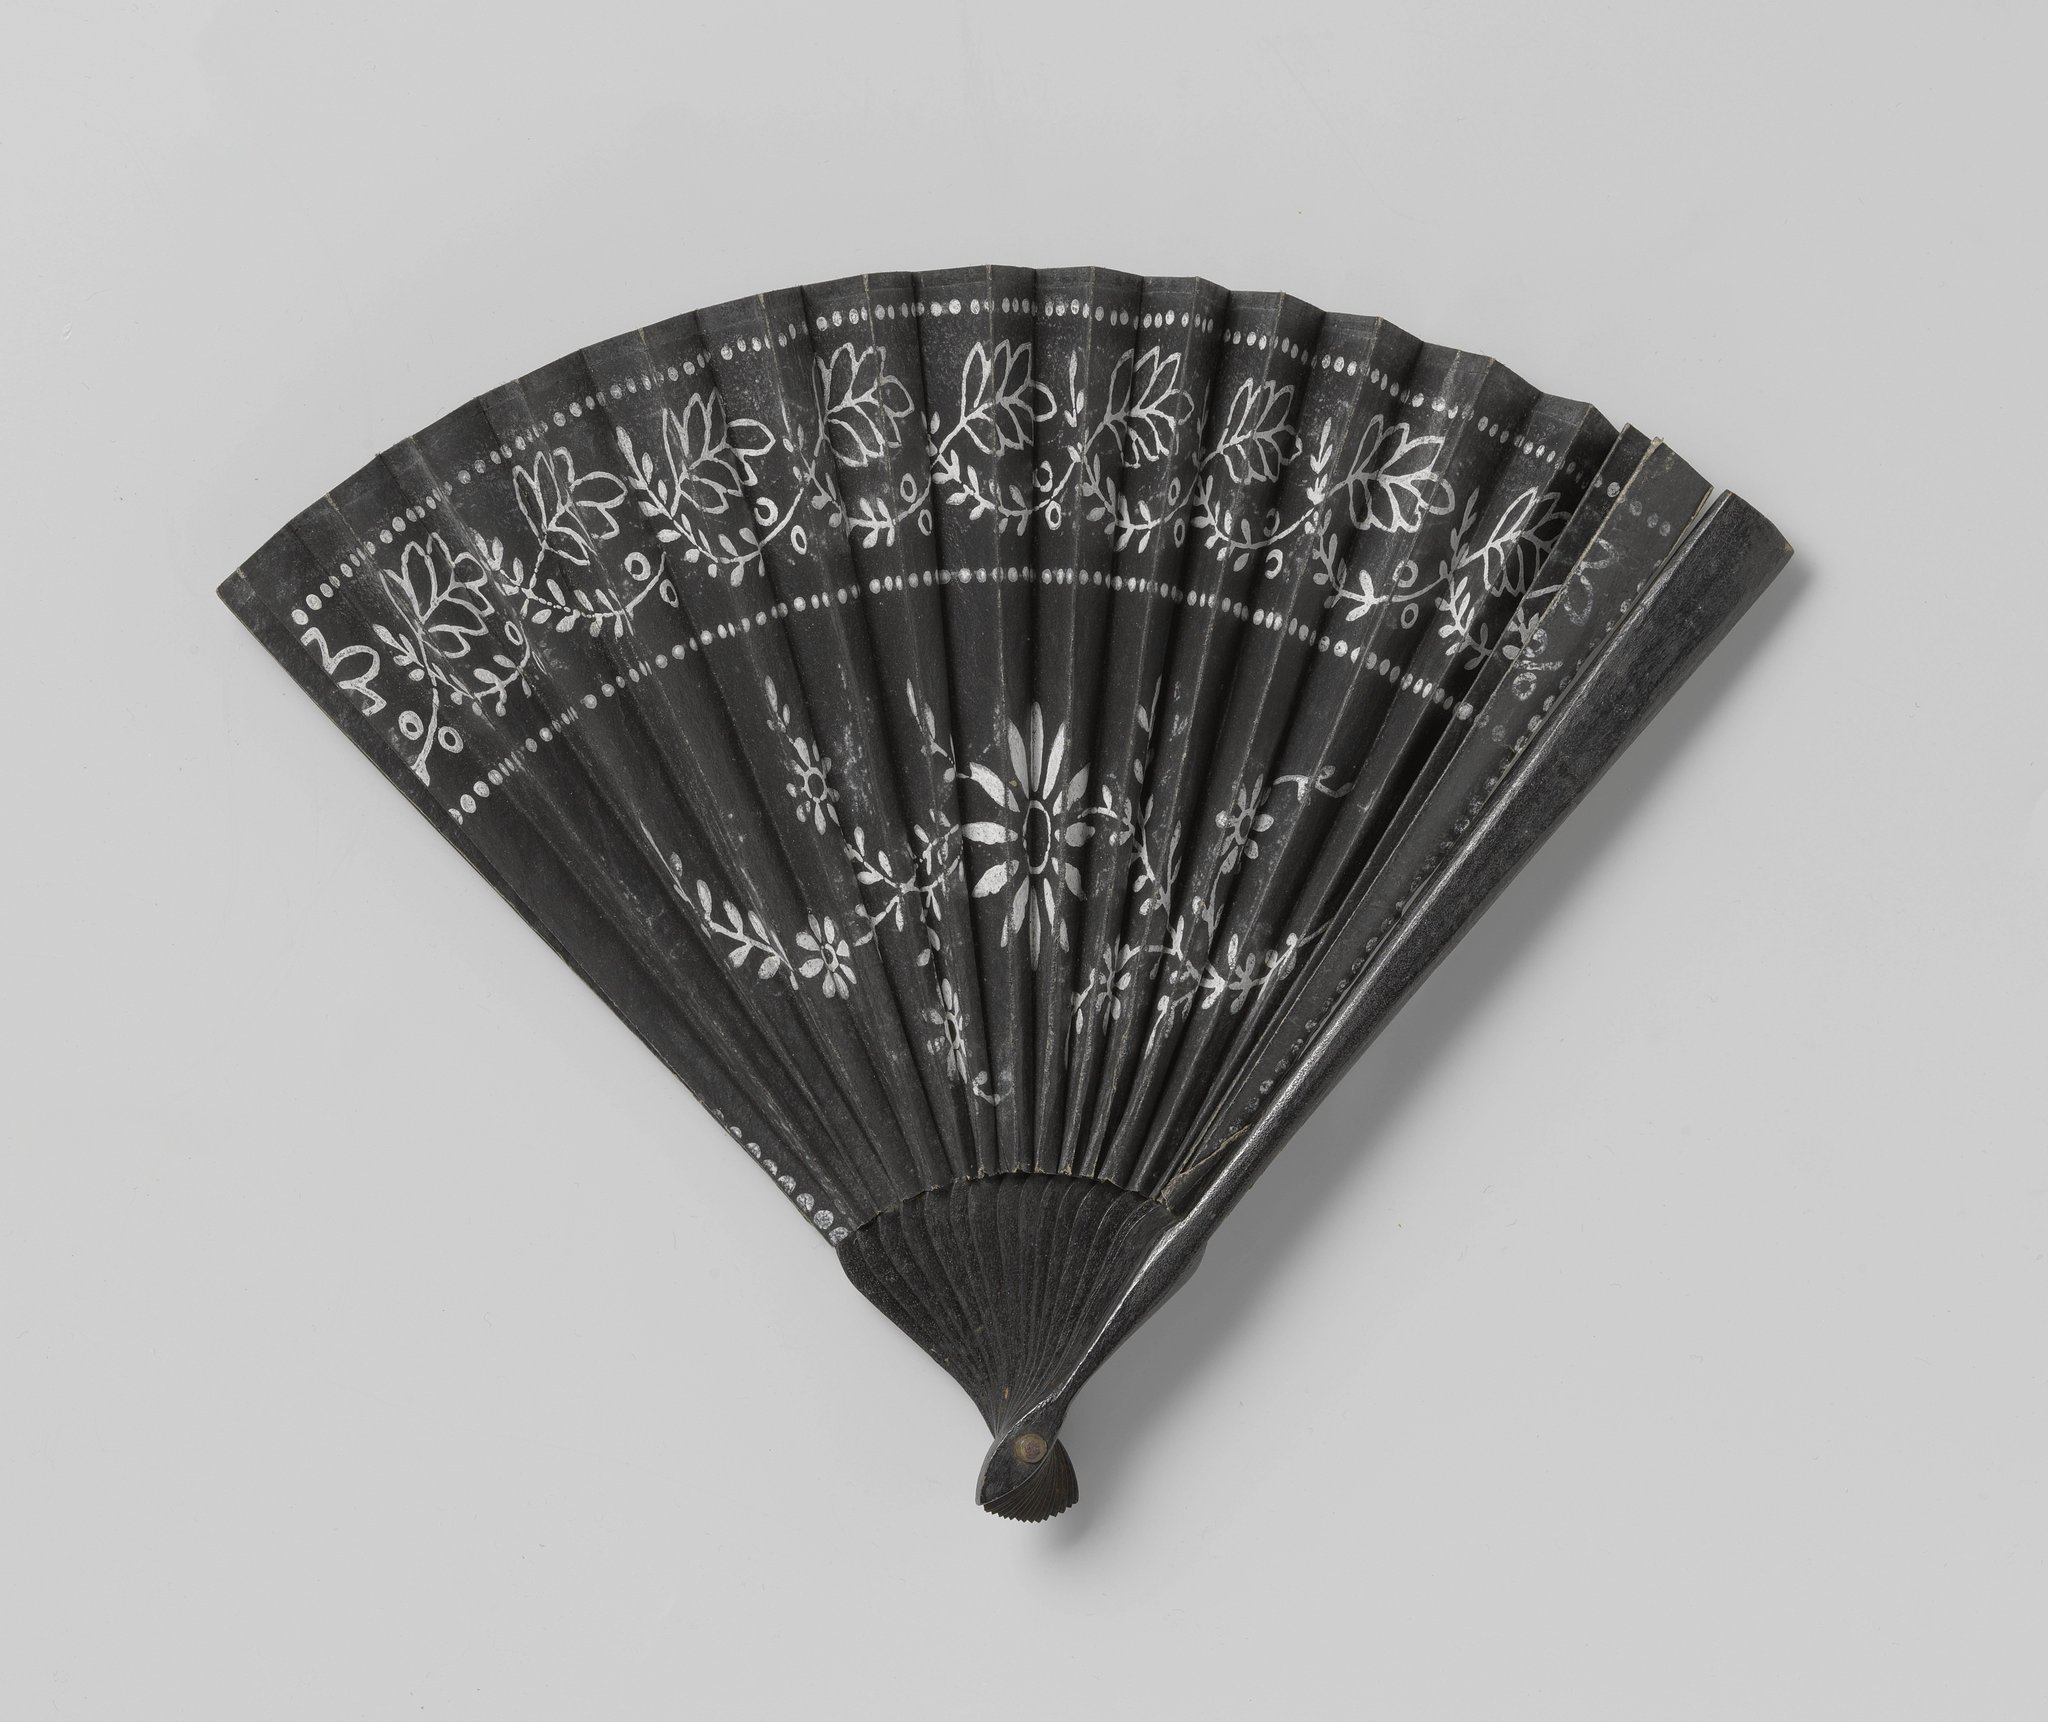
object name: rouwwaaier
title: Vouwwaaier van zwart papier met in aquarel wit floraal motief en montuur van onversierd zwartgelakt hout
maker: Anonymous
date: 1850-1899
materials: copper, paper, watercolor, wood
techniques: cutting, painted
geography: netherlands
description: Rouwwaaier van zwart papier met wit floraal motief en montuur van onversierd zwartgelakt hout.